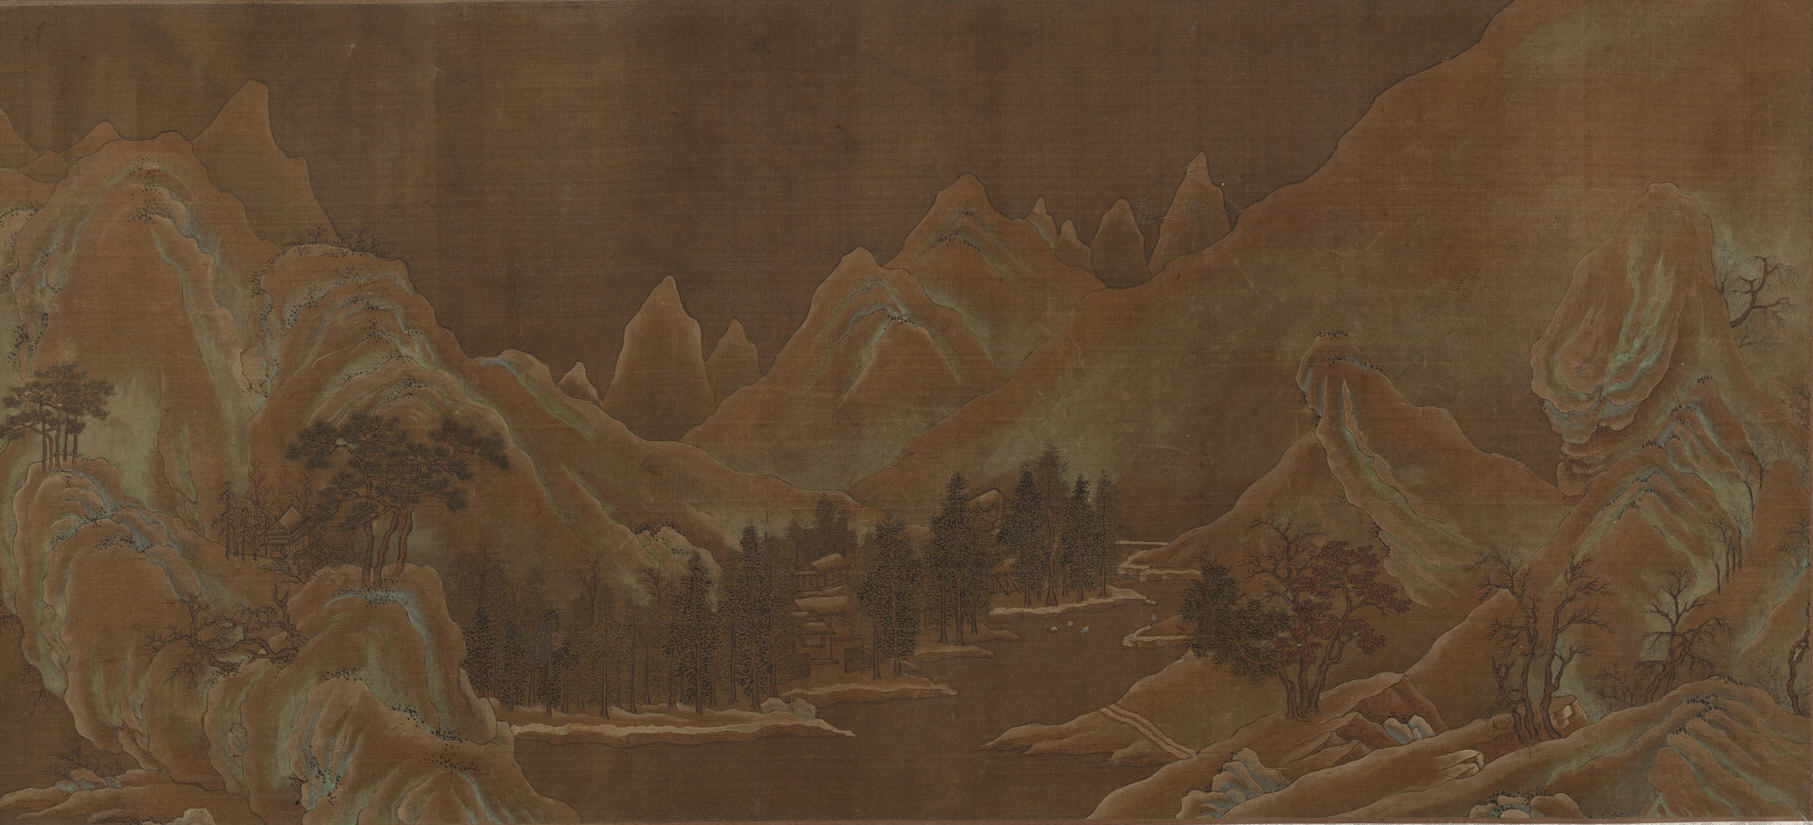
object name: handscroll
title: Landscape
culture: chinese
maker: unidentified artist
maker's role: artist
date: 1368-1911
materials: ink, silk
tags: mountains,landscapes